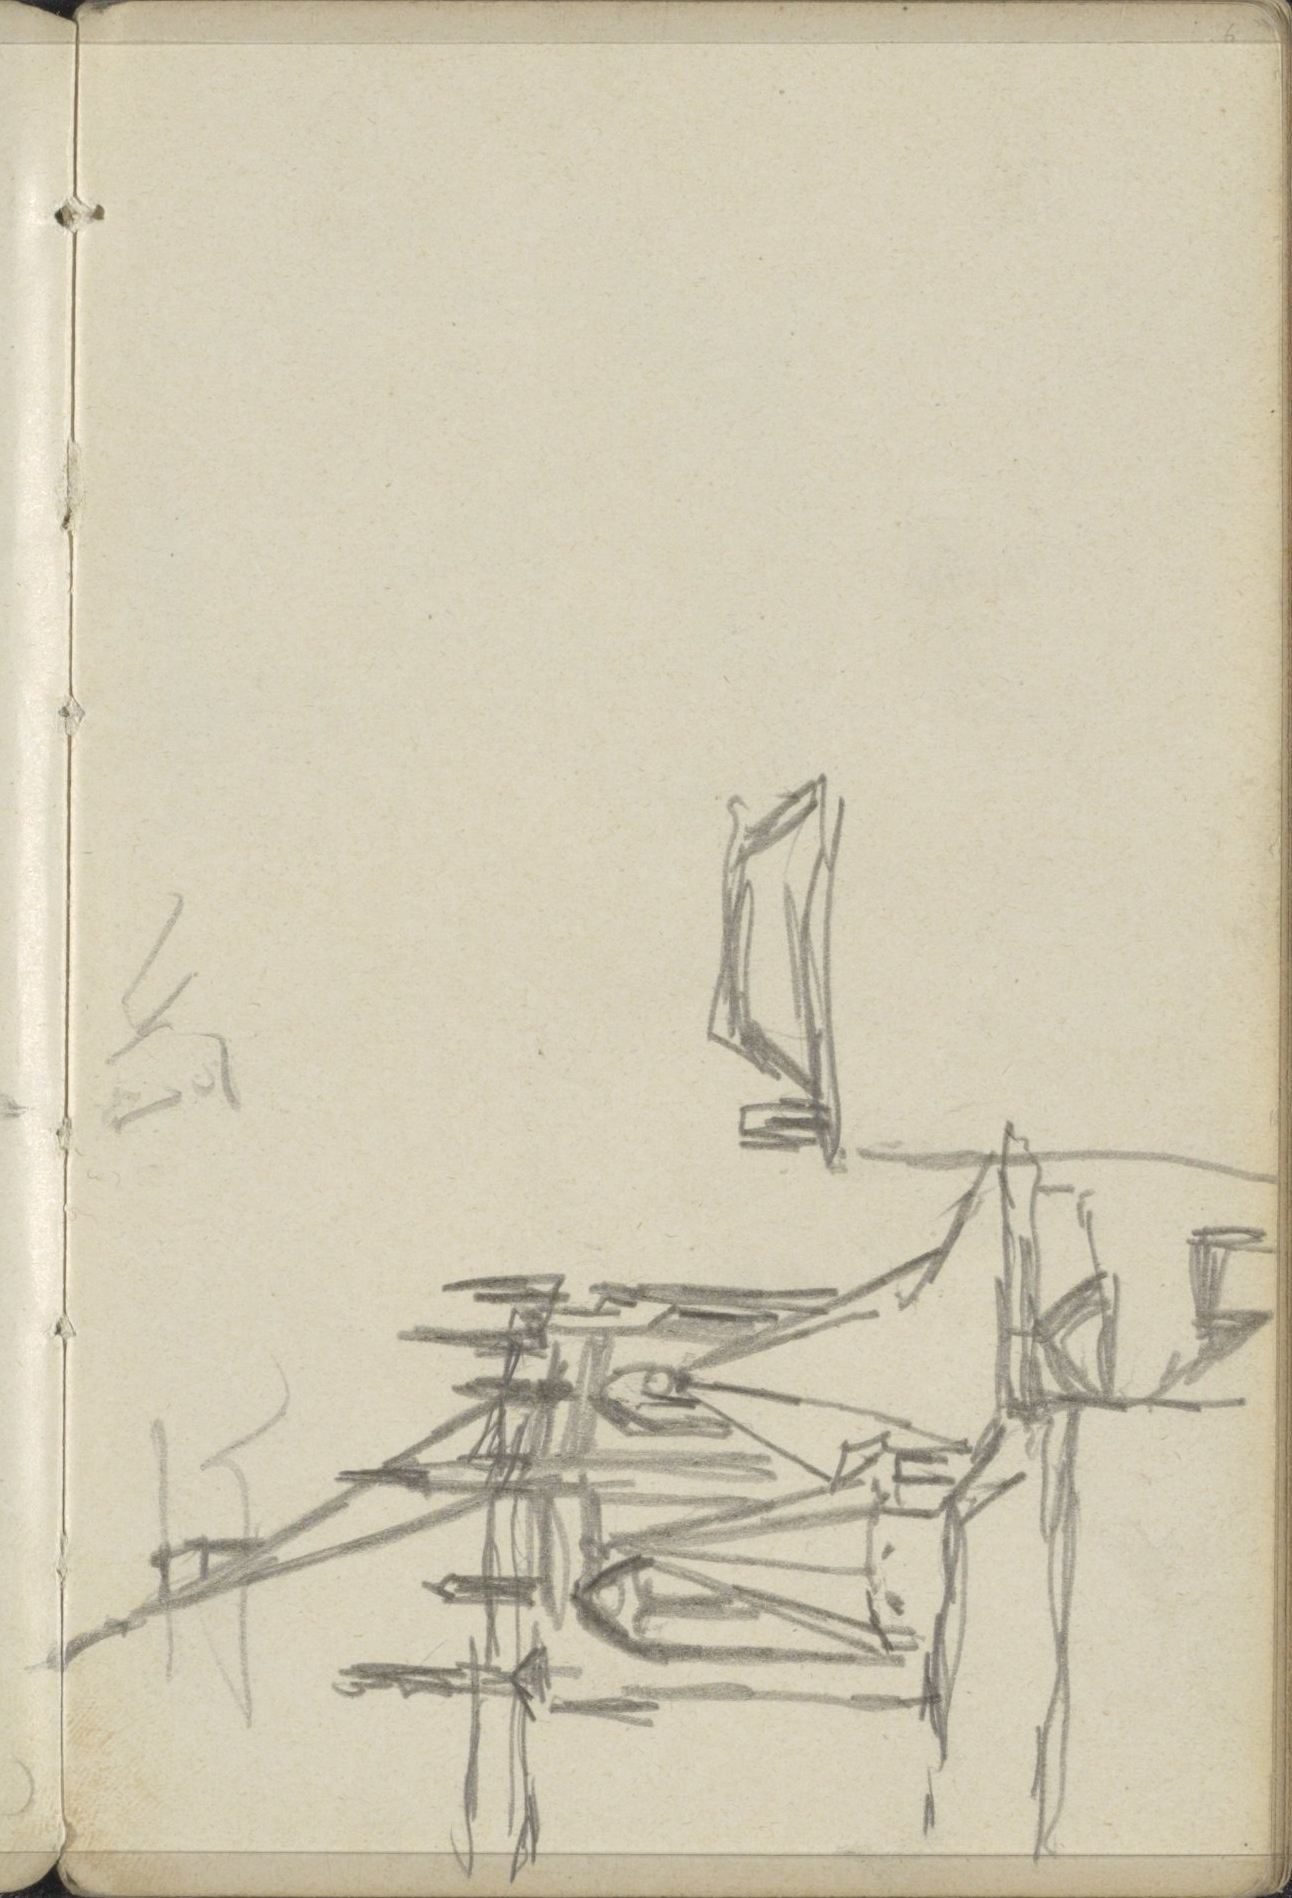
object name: sketchbook leaf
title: Koor van de Nieuwe Kerk te Amsterdam, gezien vanaf de Dam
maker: george hendrik breitner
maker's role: draughtsman, painter, print maker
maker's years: 1857-1923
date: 1910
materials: paper, pencil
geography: amsterdam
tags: parts of church exterior and annexes: choir, civic architecture; edifices; dwellings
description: Pagina 6 uit een schetsboek met 45 bladen.